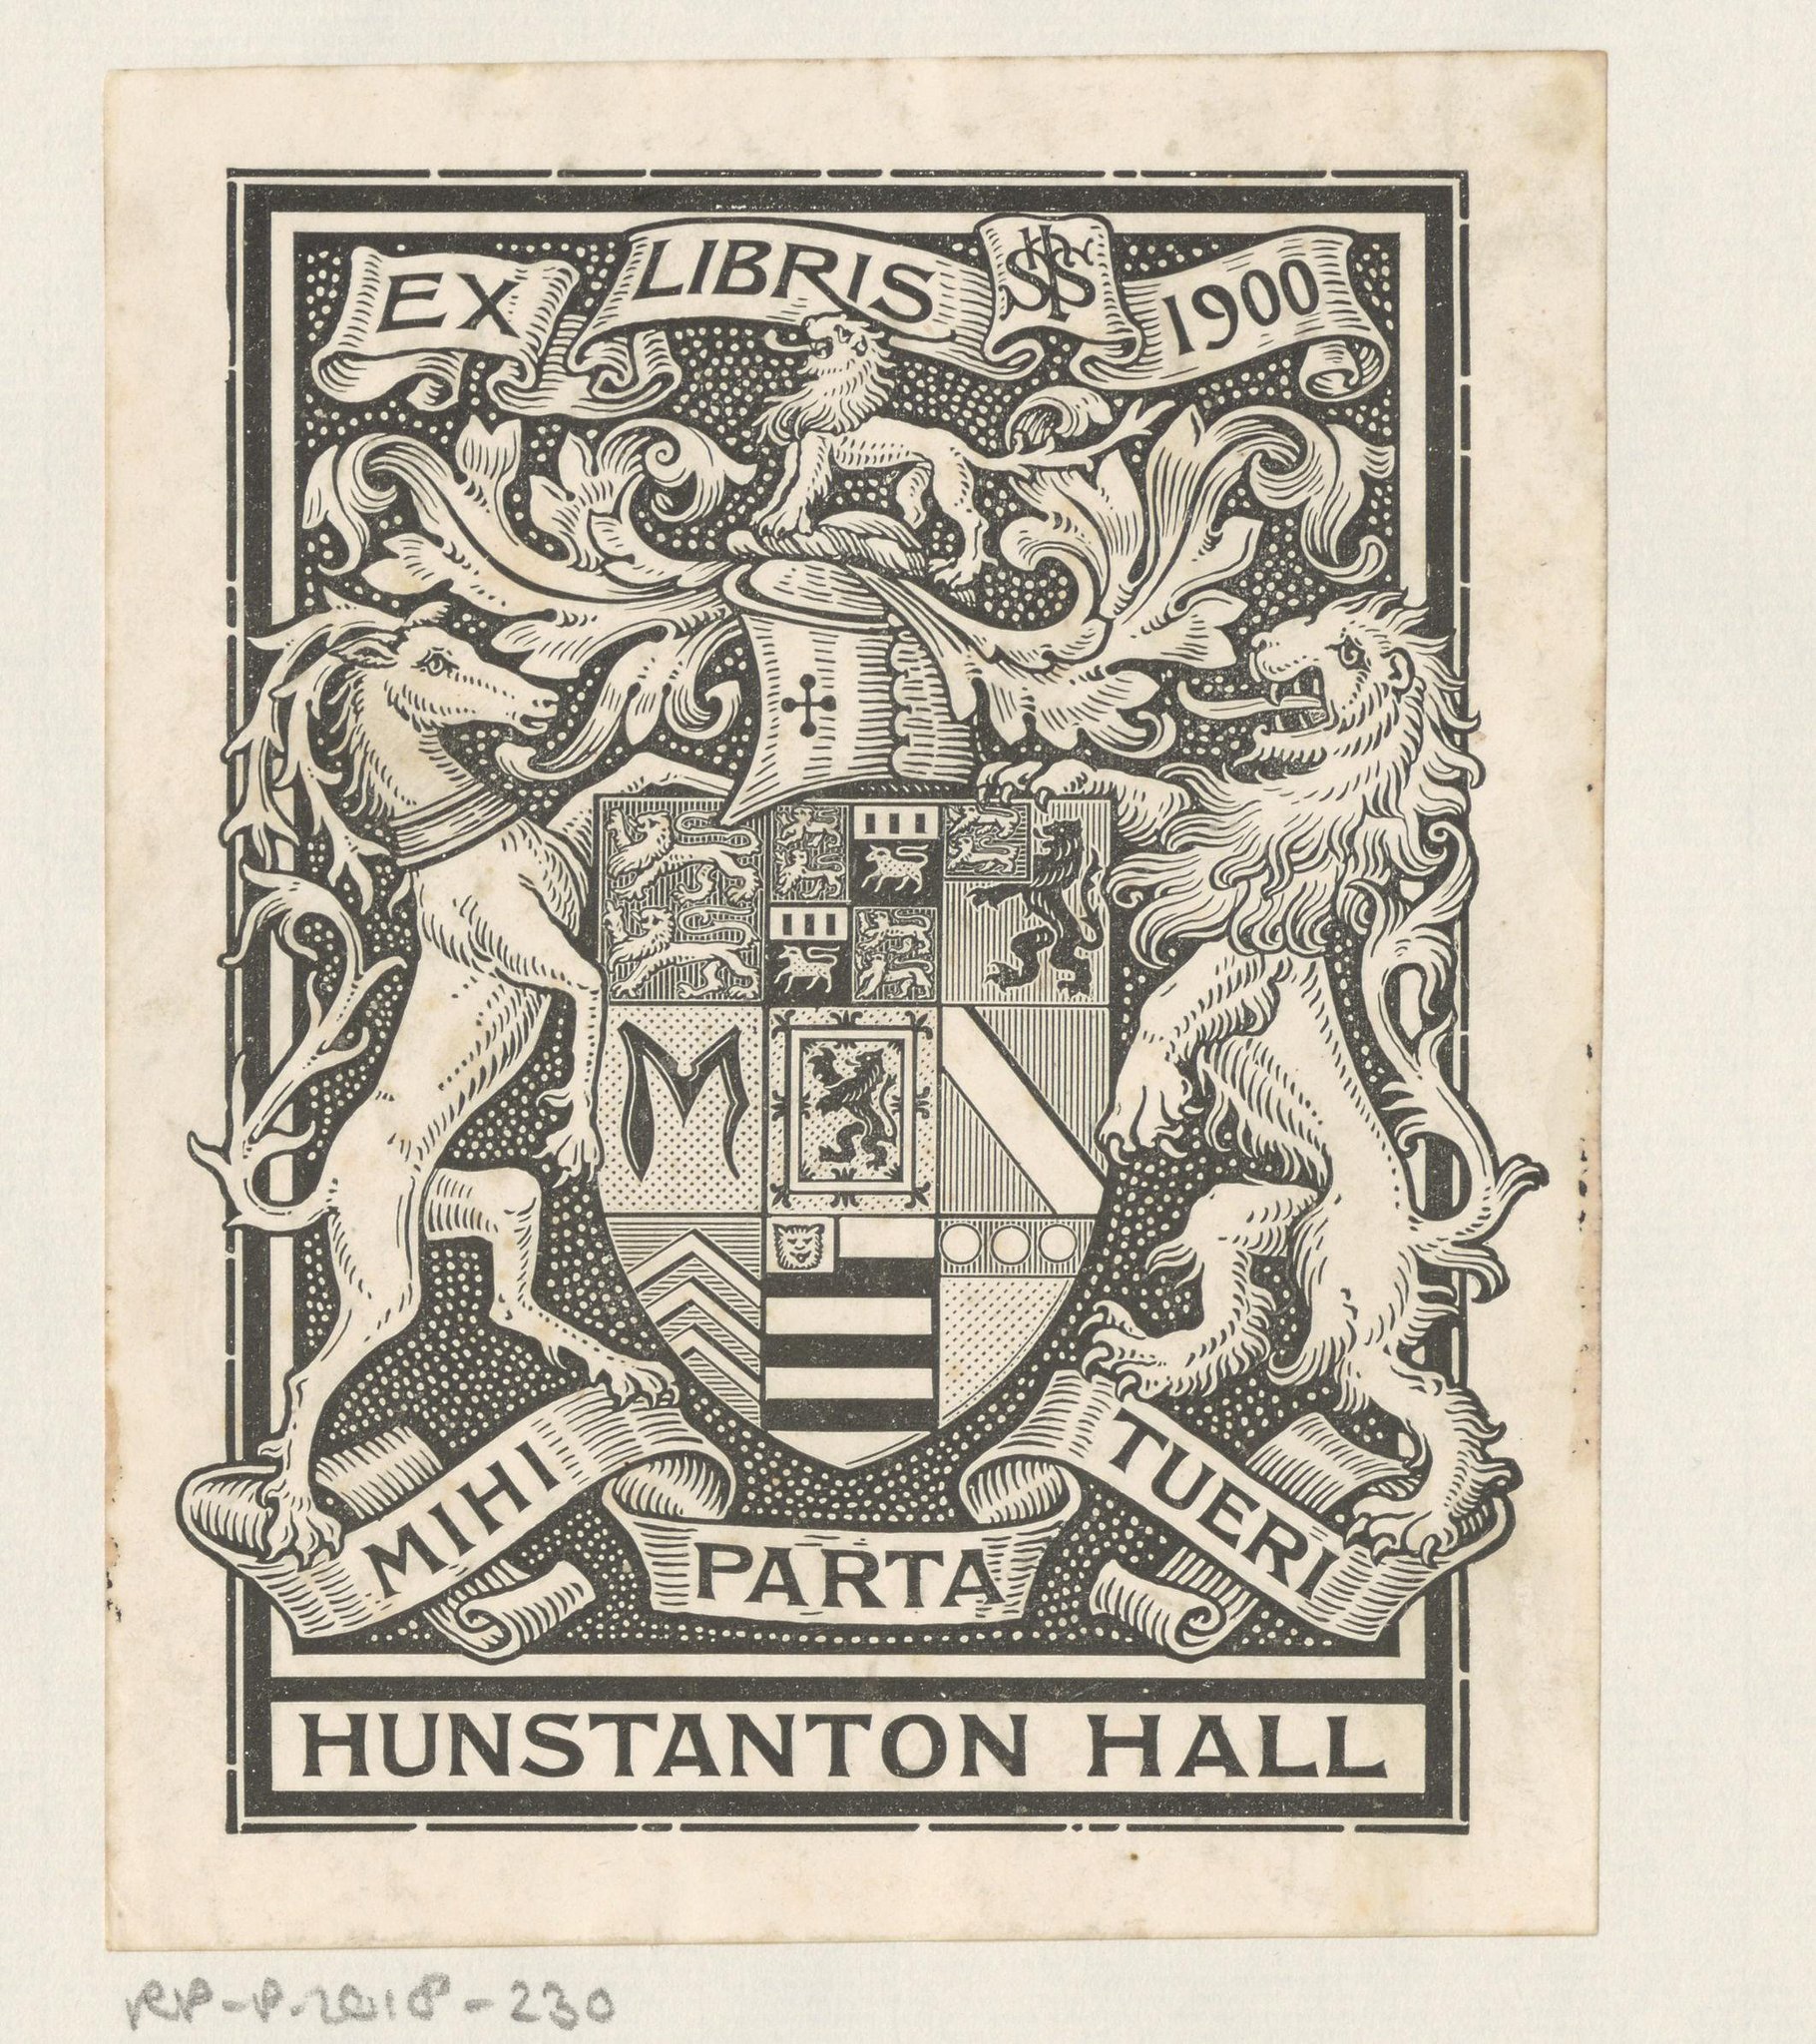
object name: bookplate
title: Ex libris van Hunstanton Hall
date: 1900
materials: paper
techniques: printing block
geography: england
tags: hoofed animals: stag, beasts of prey, predatory animals: lion, armorial bearing, heraldry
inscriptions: date